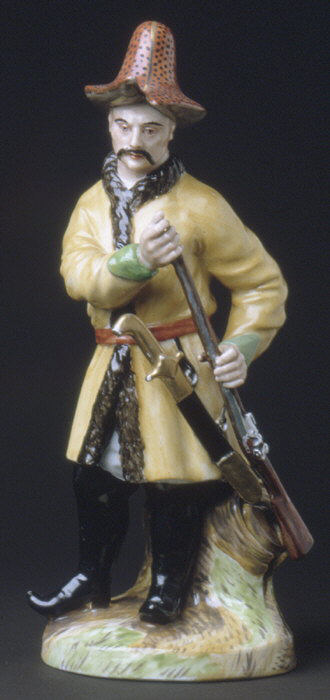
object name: figure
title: Kirghiz Man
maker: imperial porcelain manufactory, st. petersburg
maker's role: manufactory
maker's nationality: russian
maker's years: 1744-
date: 1780-1800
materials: hard paste porcelain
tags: firearms,men